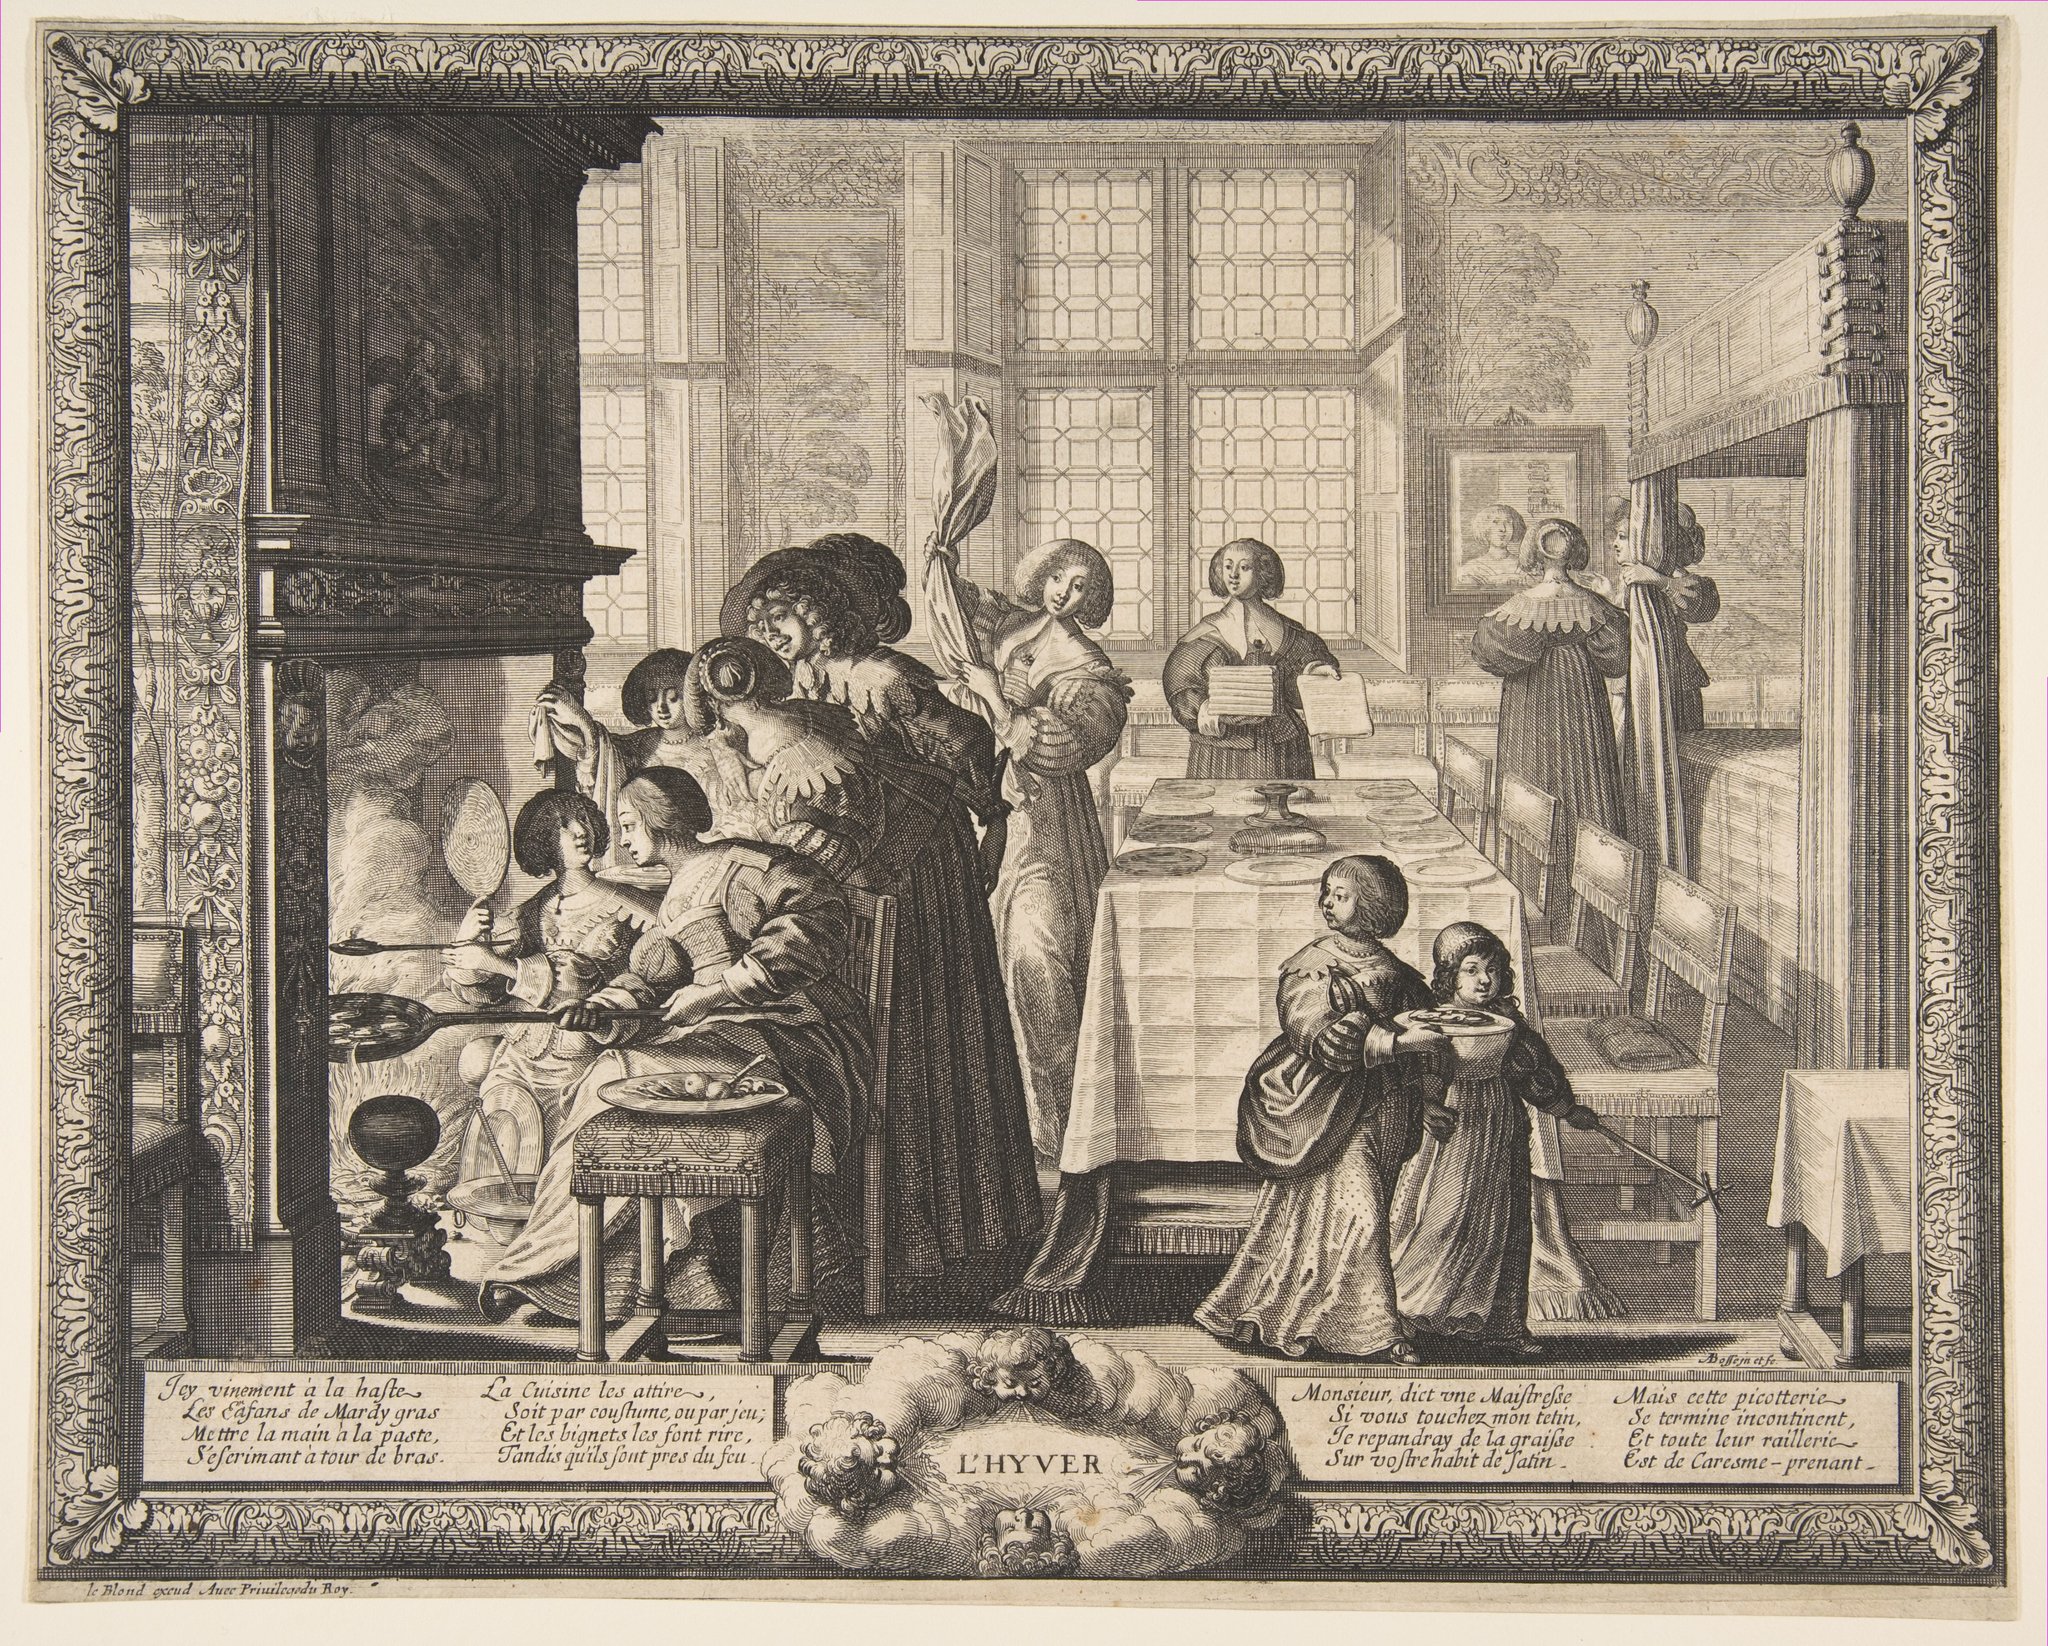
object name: print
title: Winter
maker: abraham bosse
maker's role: artist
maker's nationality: french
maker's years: 1602-1676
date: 1637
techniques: etching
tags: fireplaces,women,winter